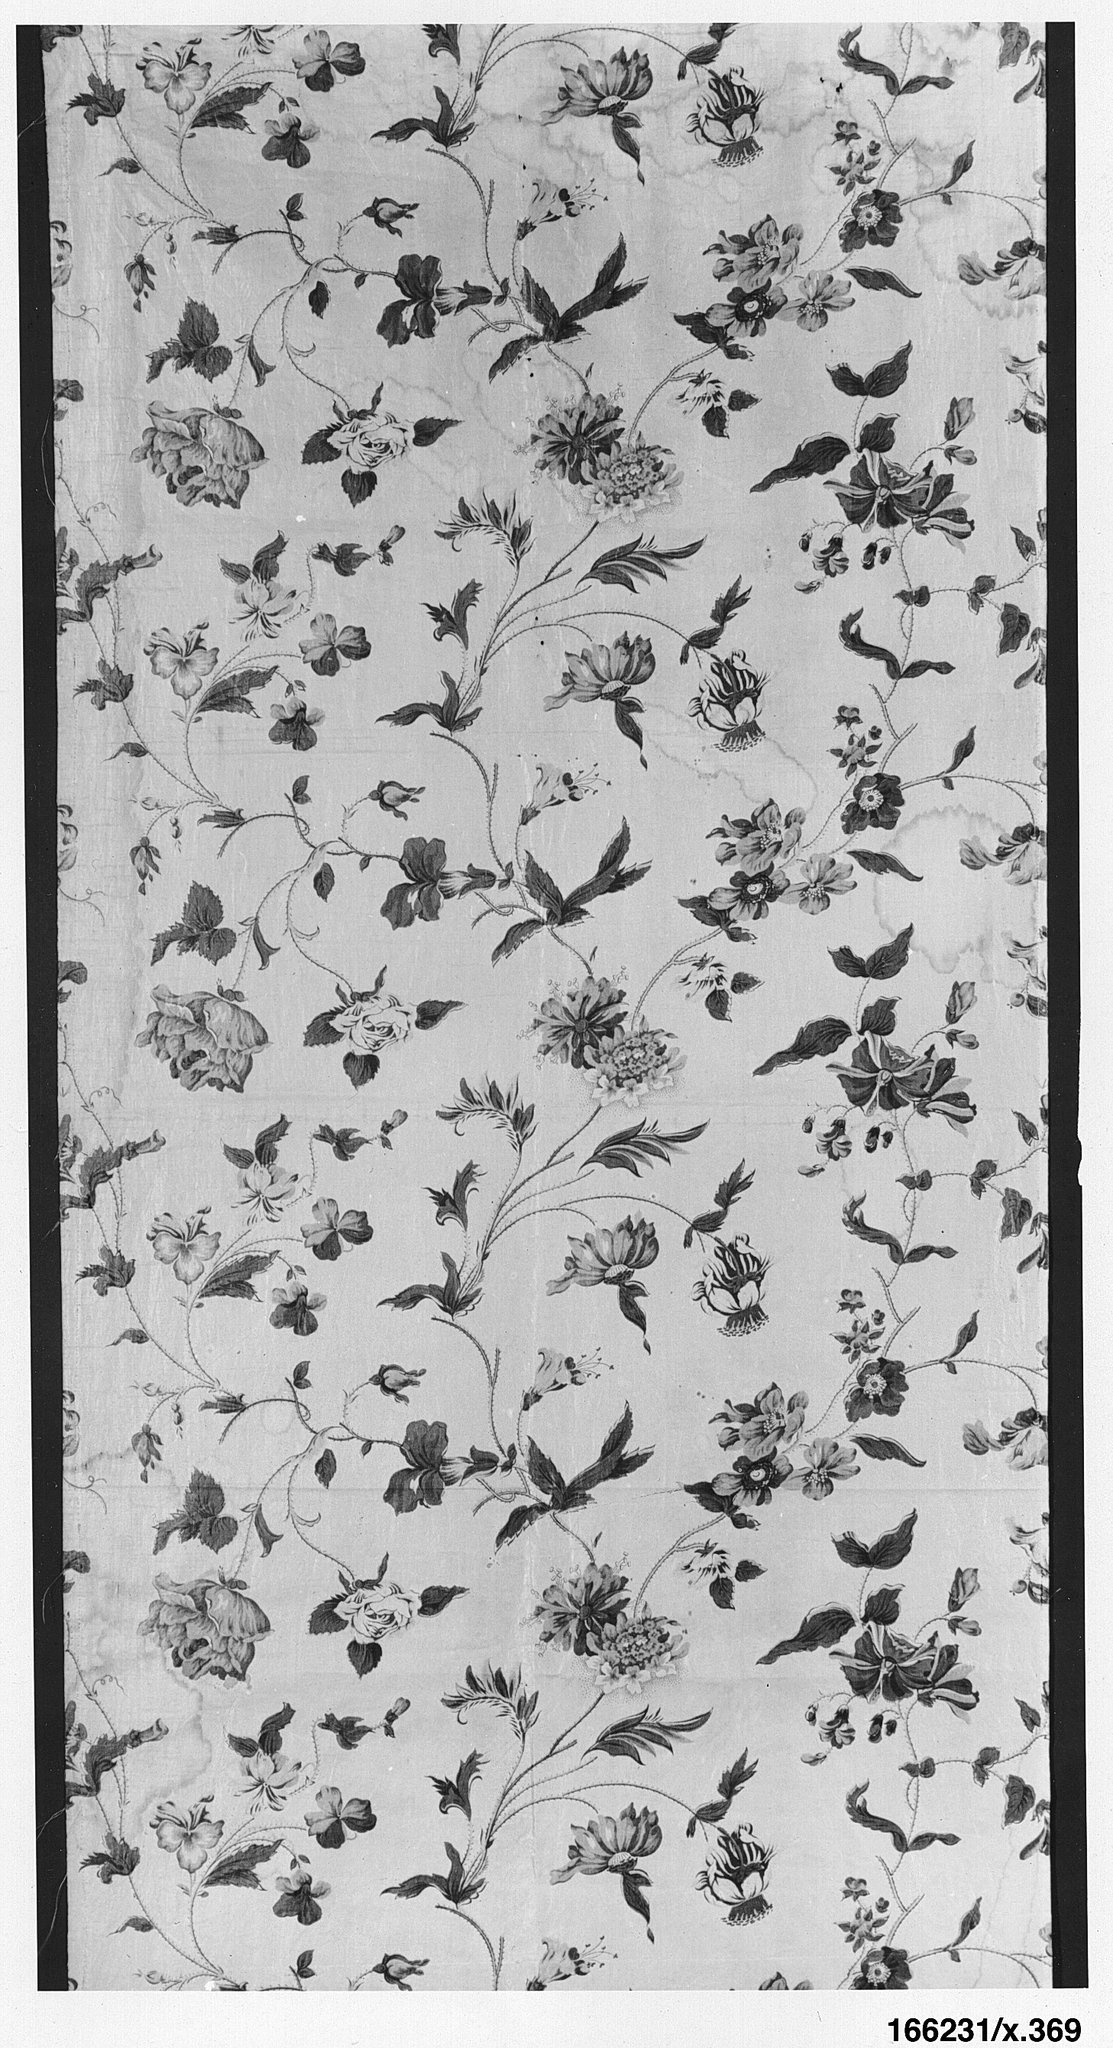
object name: piece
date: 1830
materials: cotton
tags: flowers,leaves